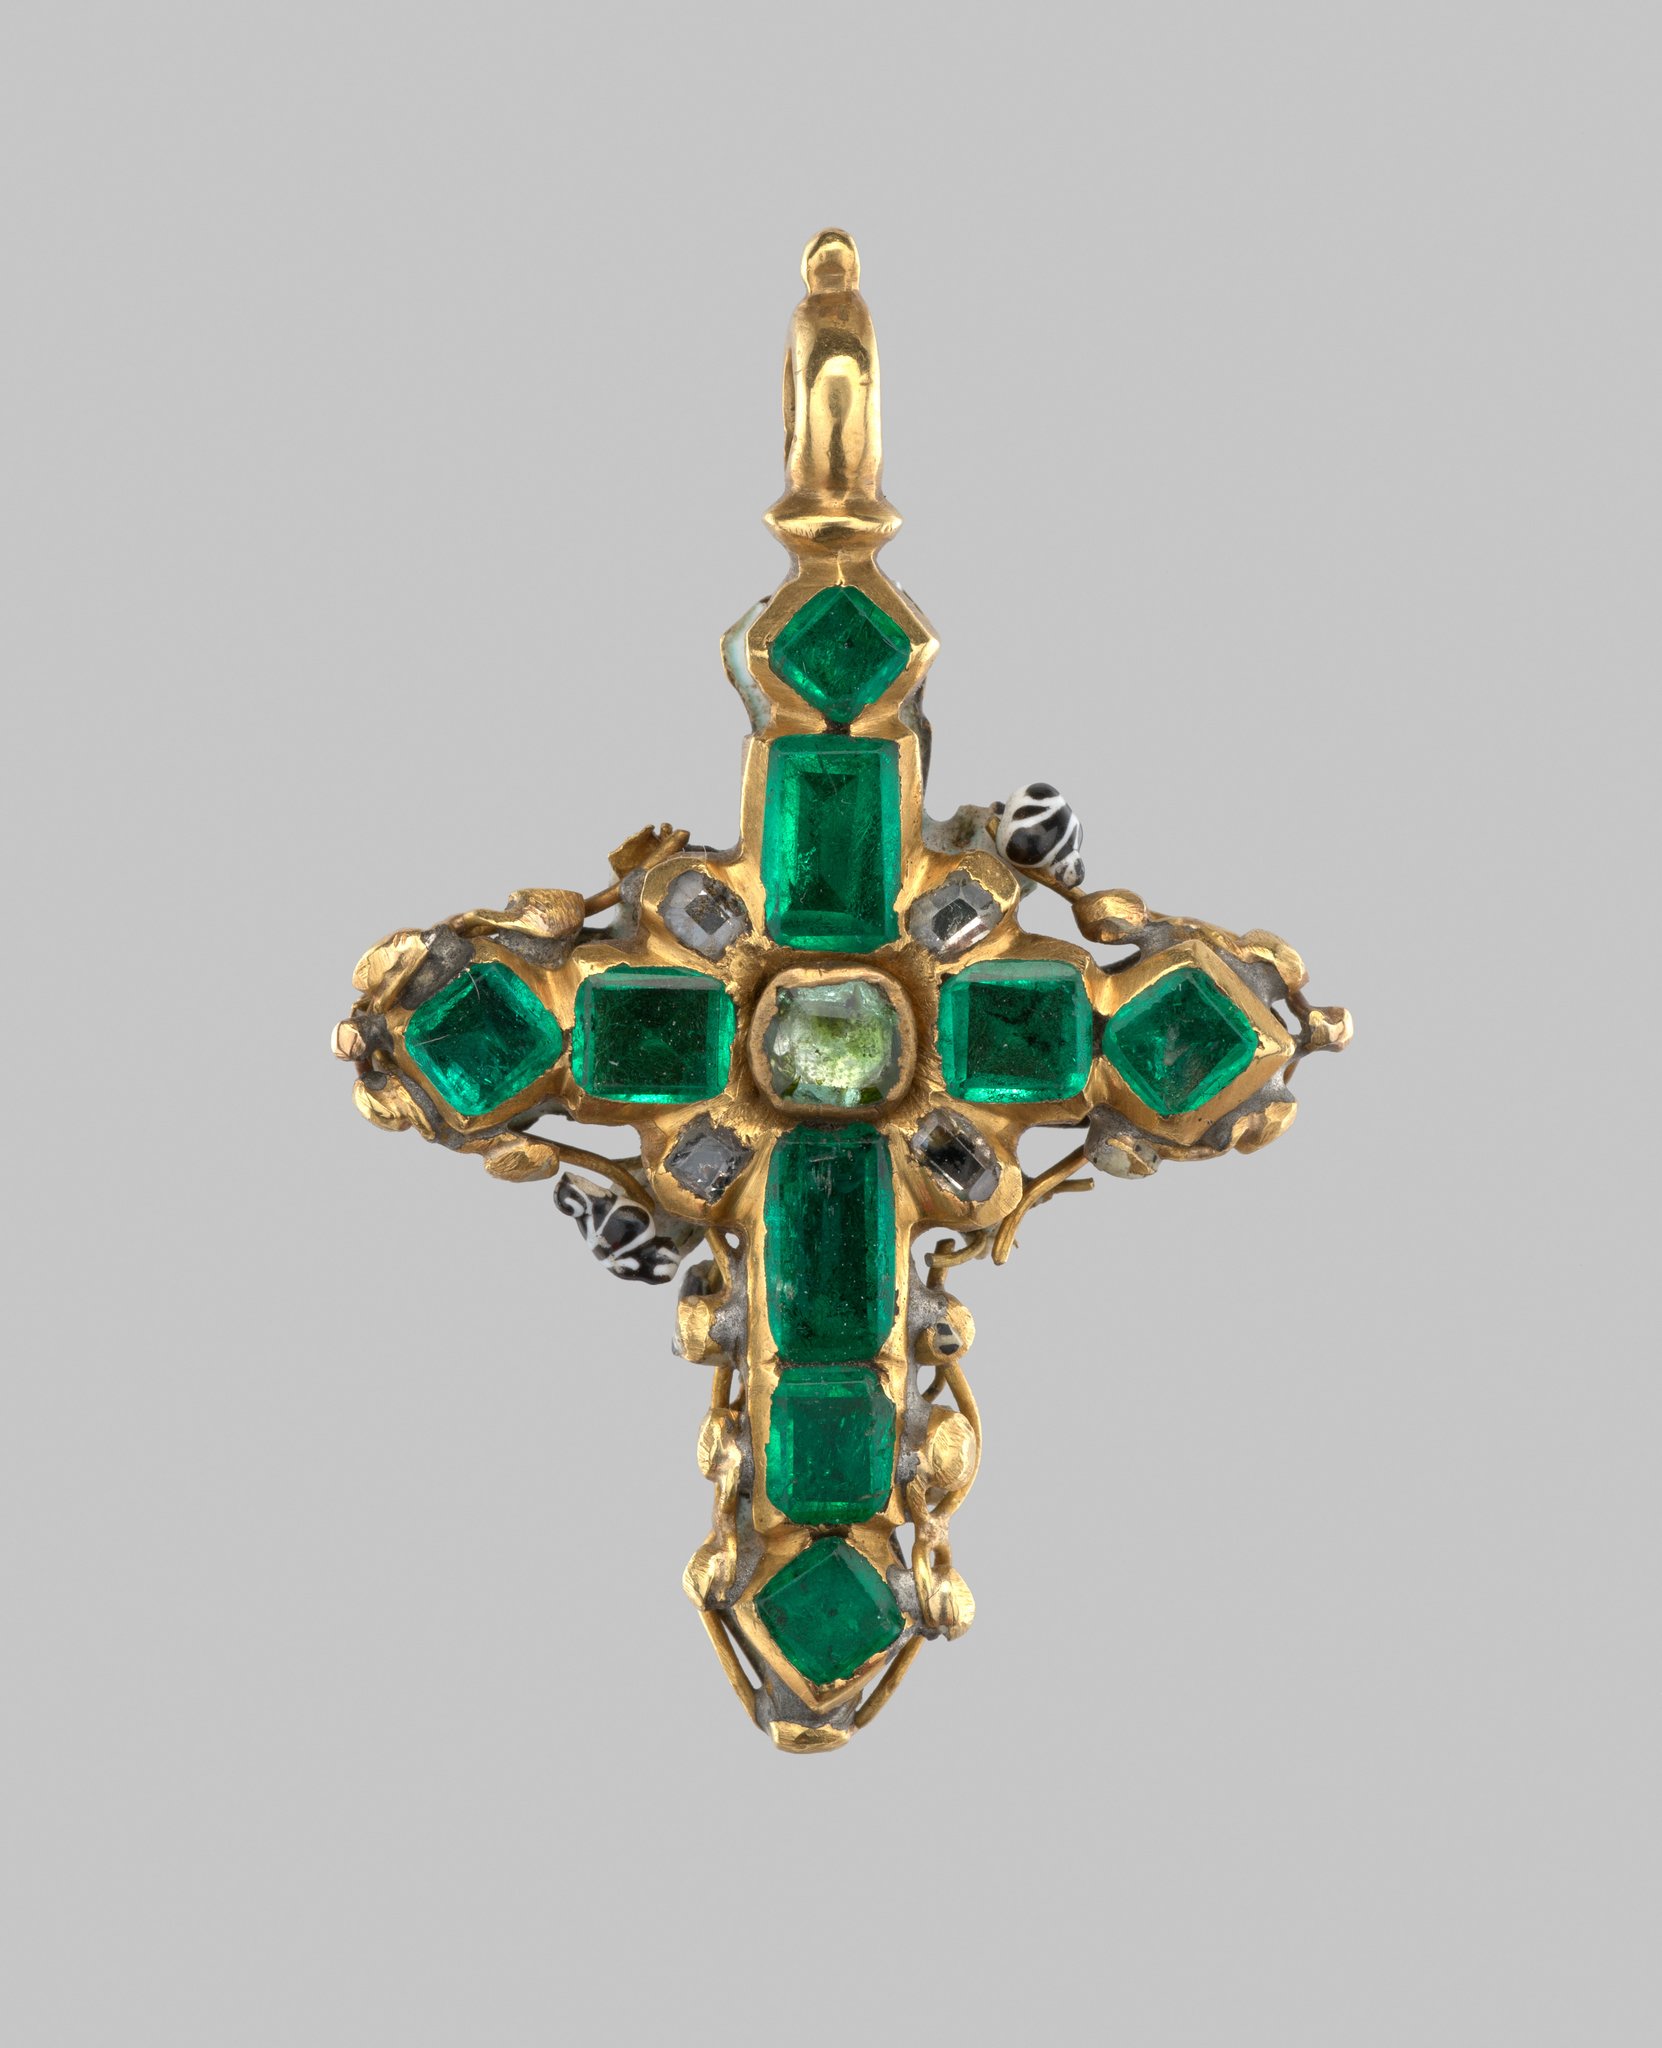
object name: pendant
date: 1650-1675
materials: diamond, gemstone, enamel, gold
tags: cross